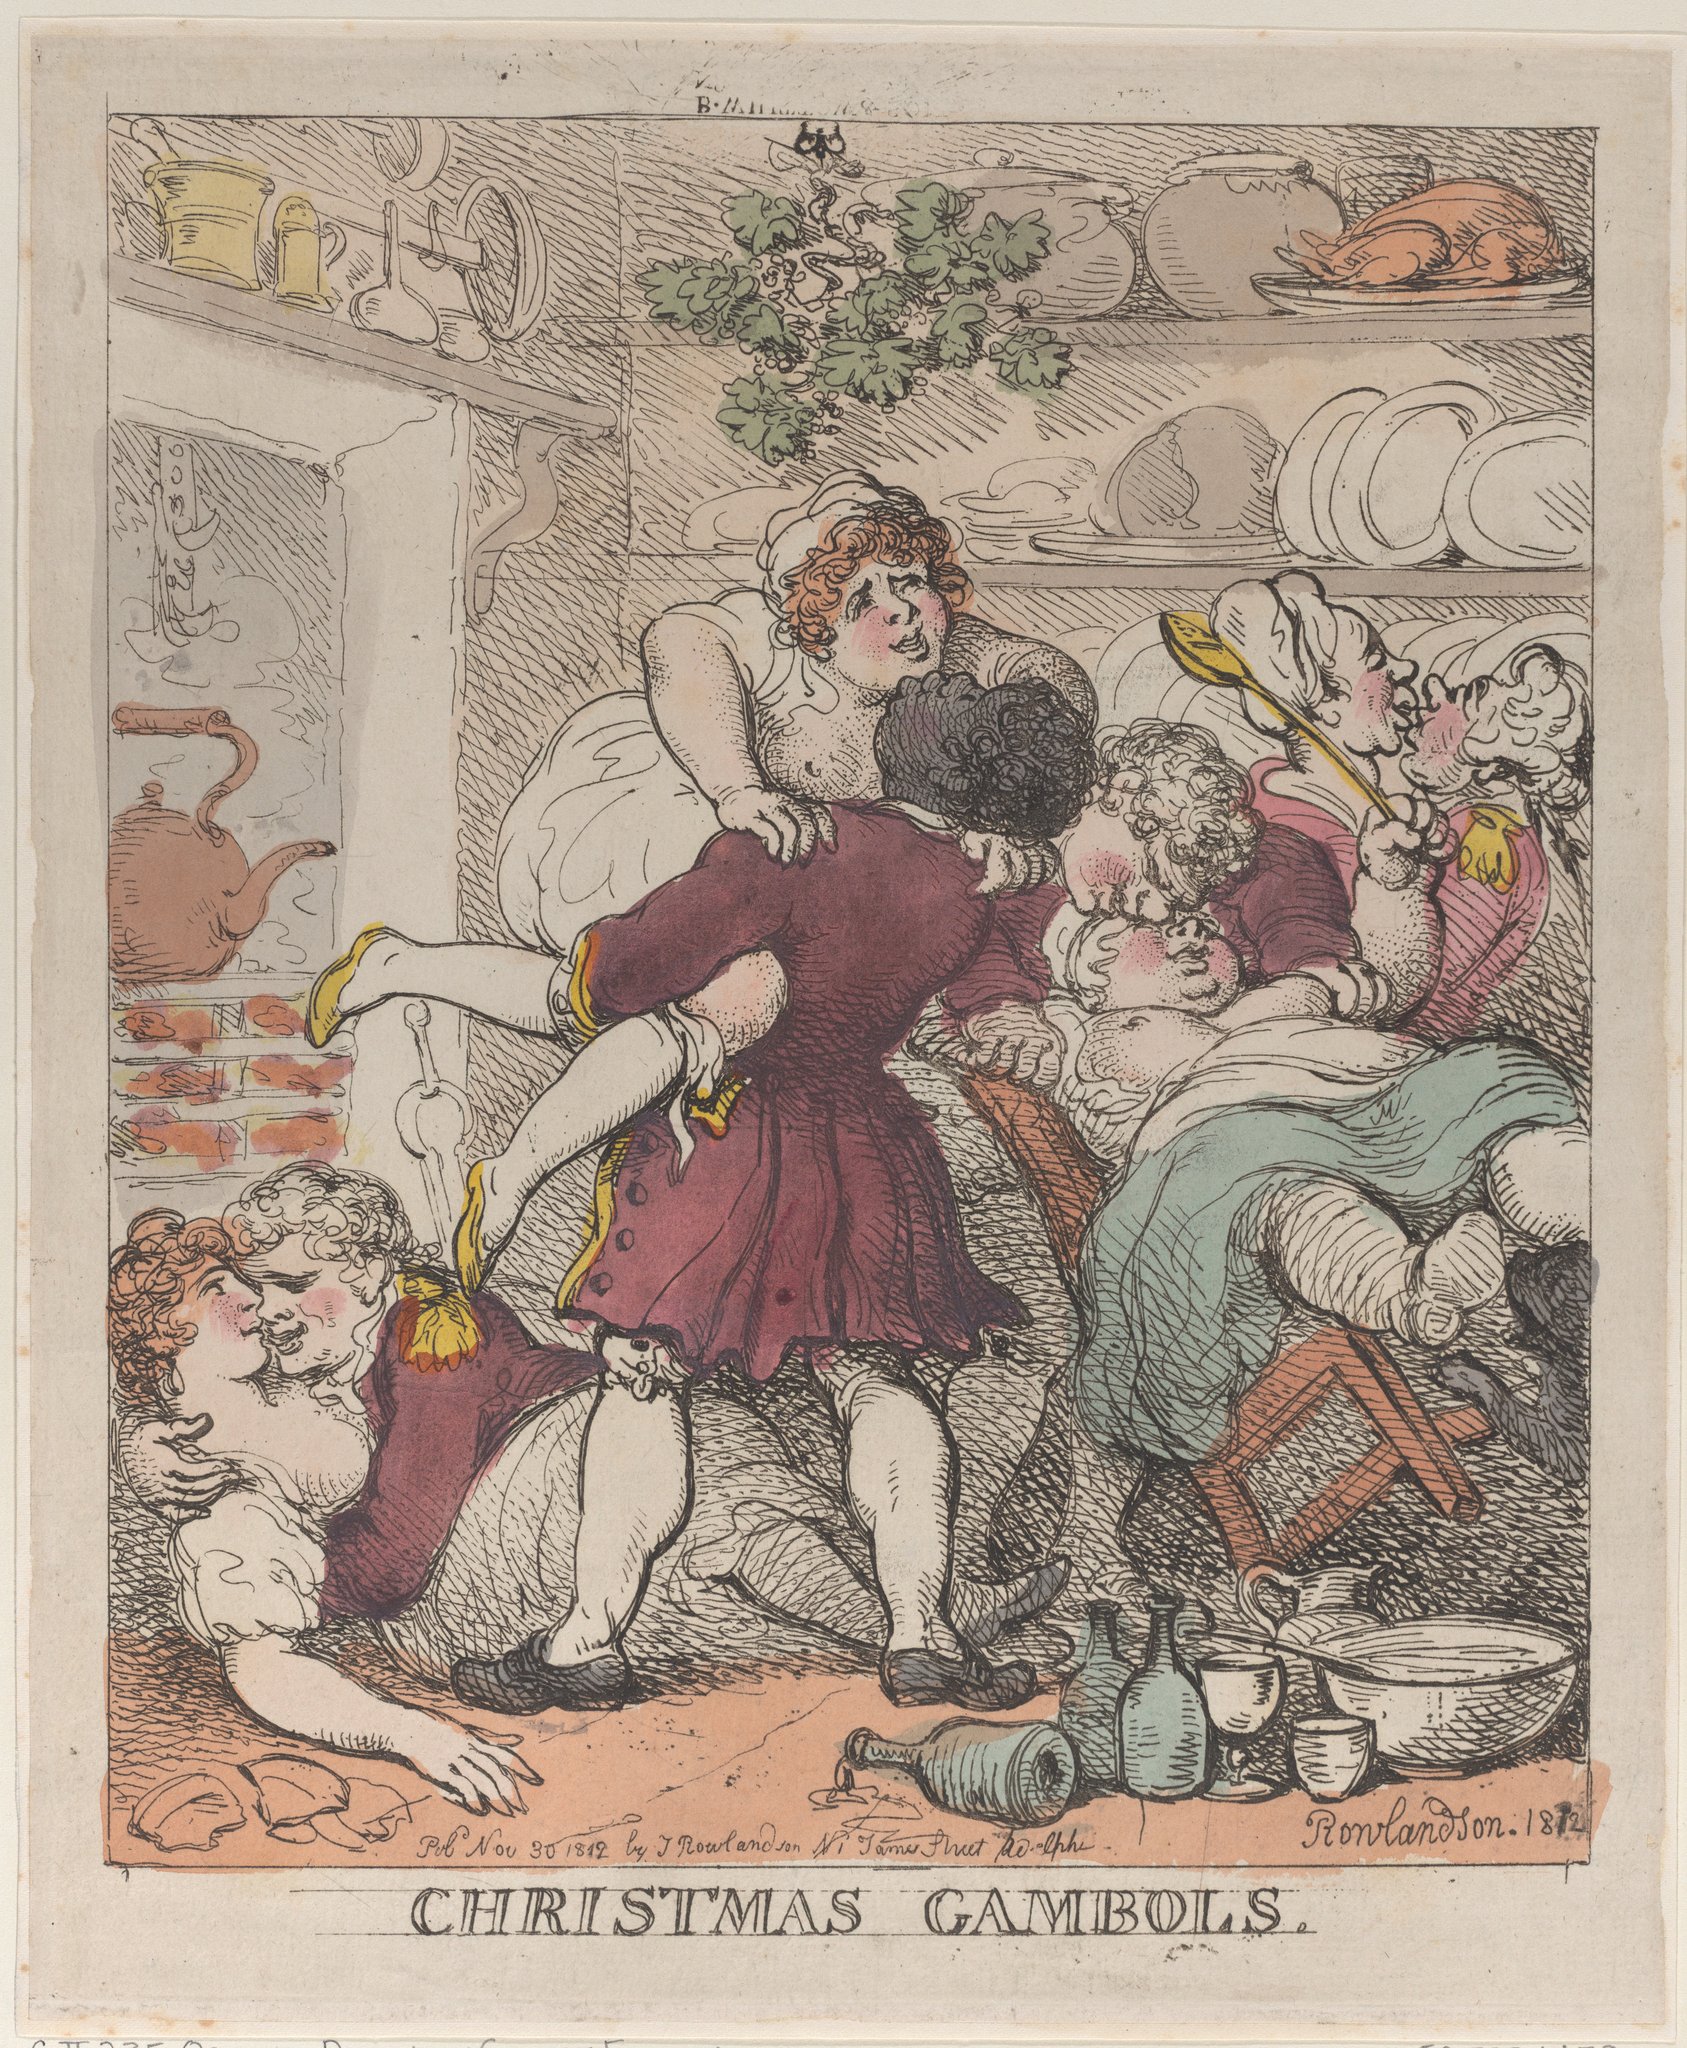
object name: print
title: Christmas Gambols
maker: thomas rowlandson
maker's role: artist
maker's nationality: british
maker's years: 1757-1827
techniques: etching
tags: satire,couples,men,women